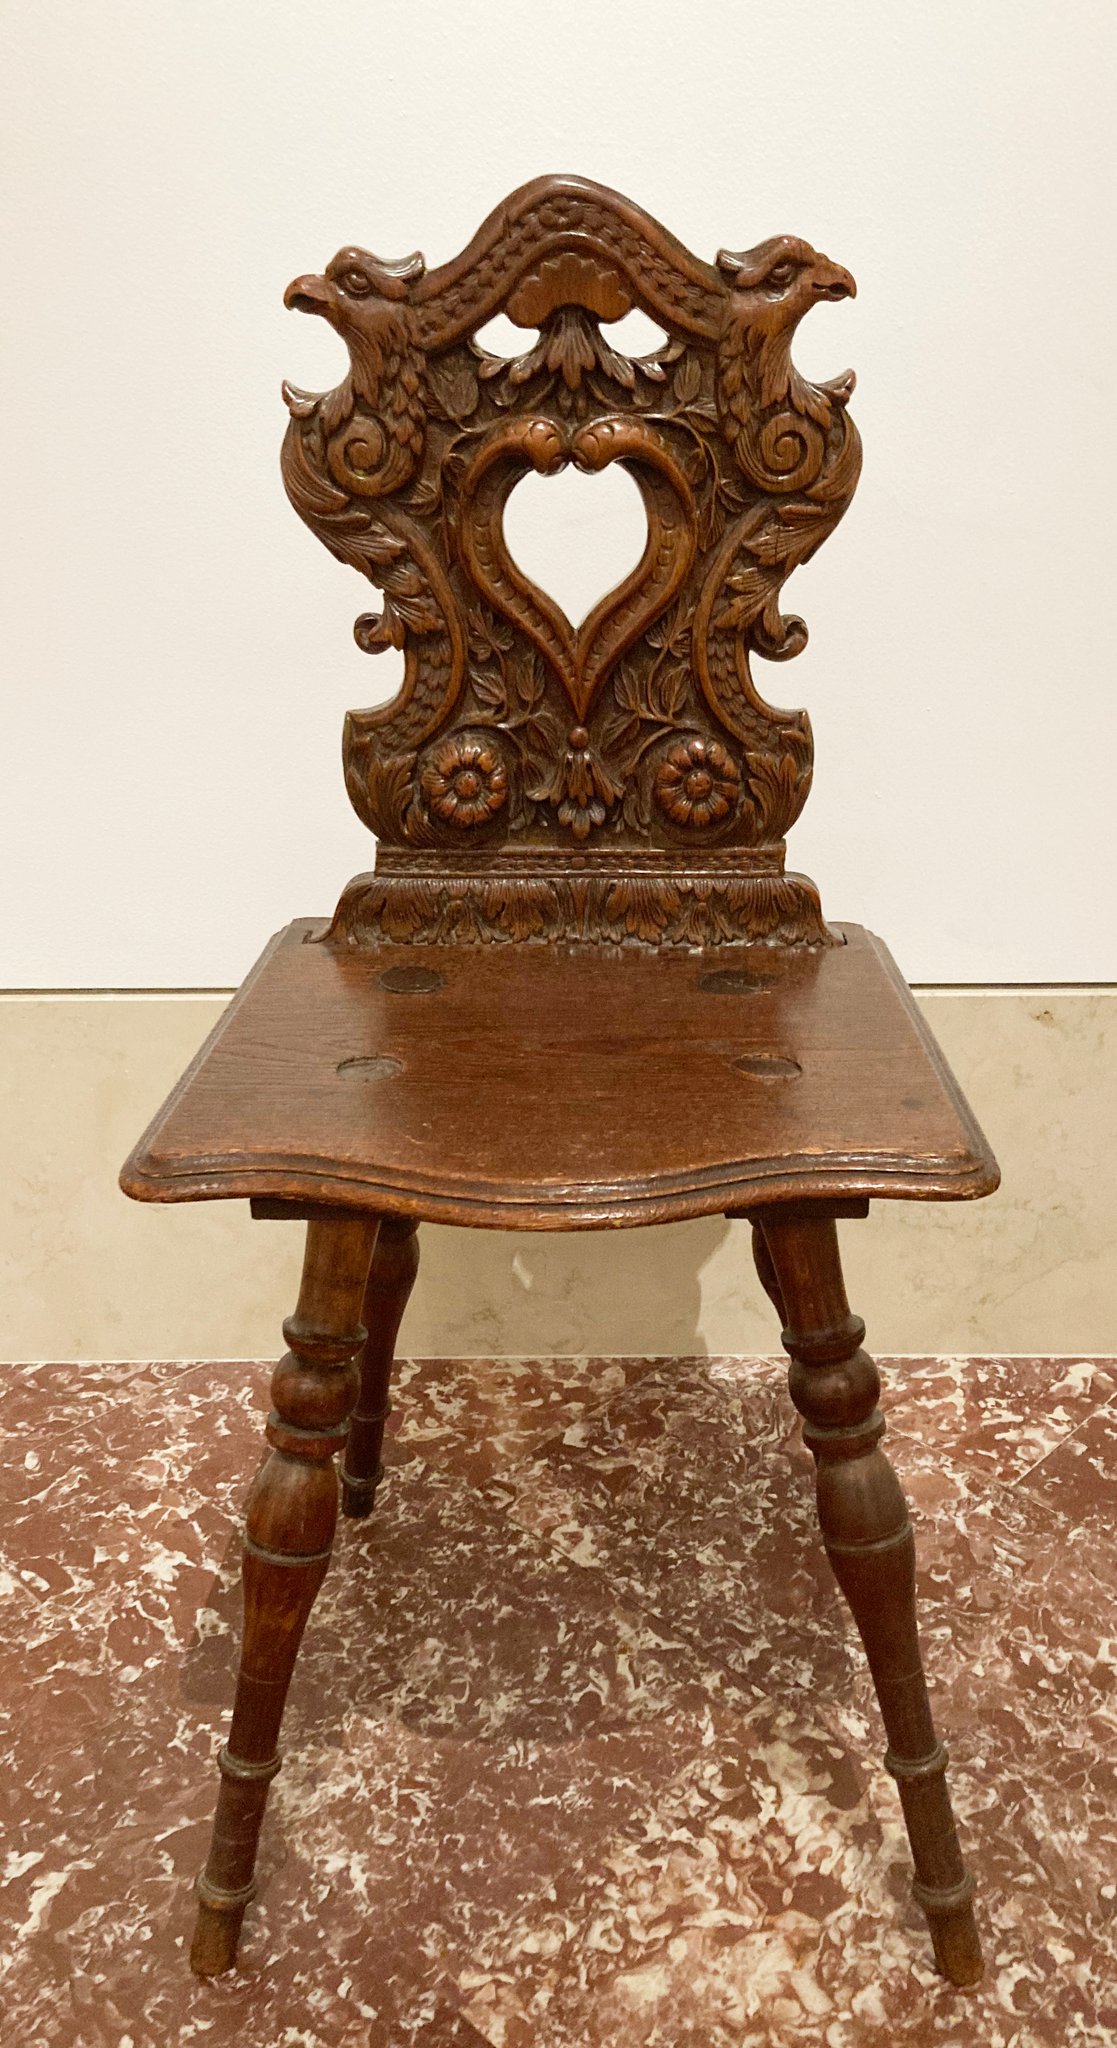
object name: sgabello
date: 1701-1800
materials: wood